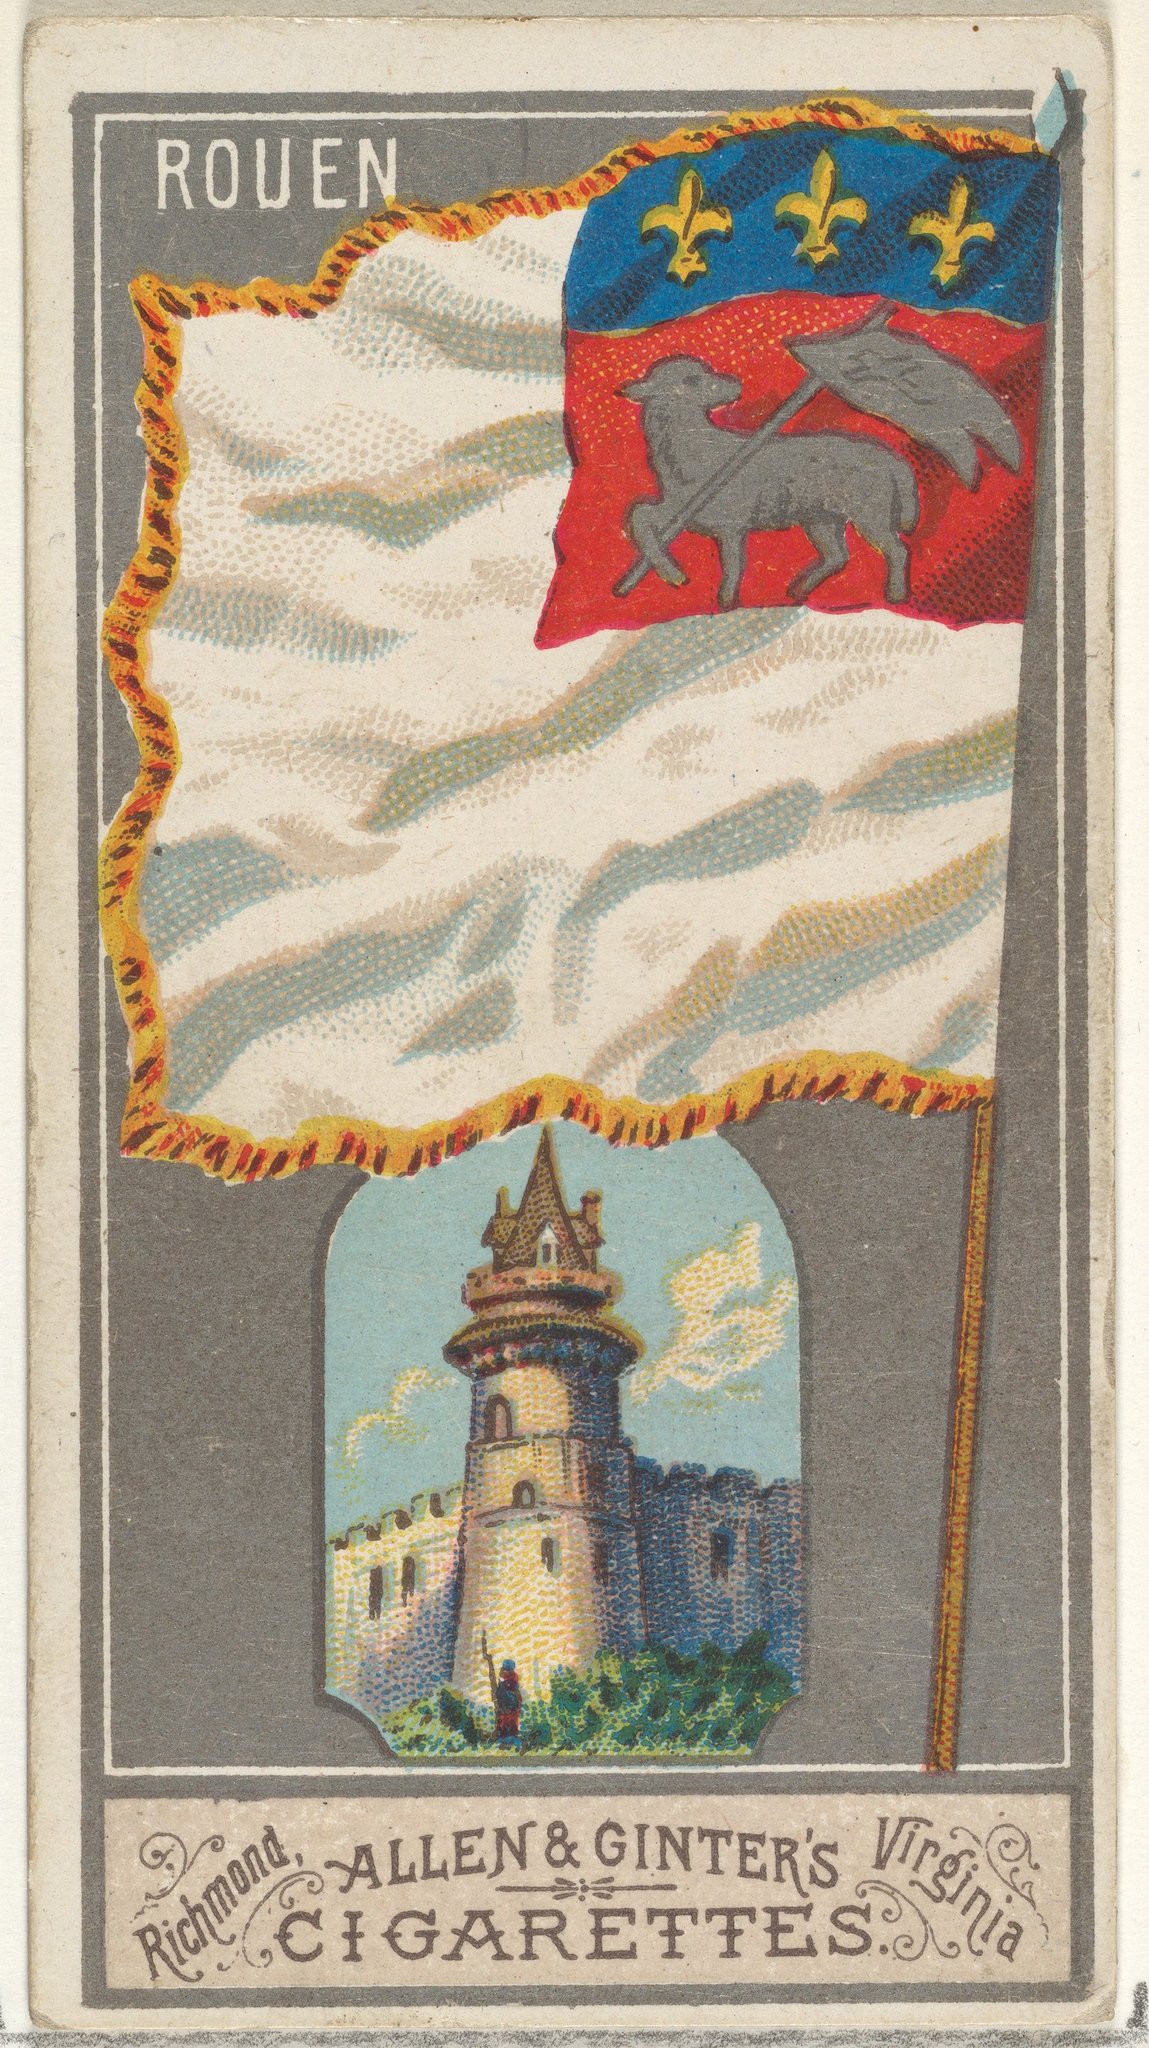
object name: print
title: Rouen, from the City Flags series (N6) for Allen & Ginter Cigarettes Brands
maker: allen & ginter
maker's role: publisher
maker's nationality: american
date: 1887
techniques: color lithograph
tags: flags